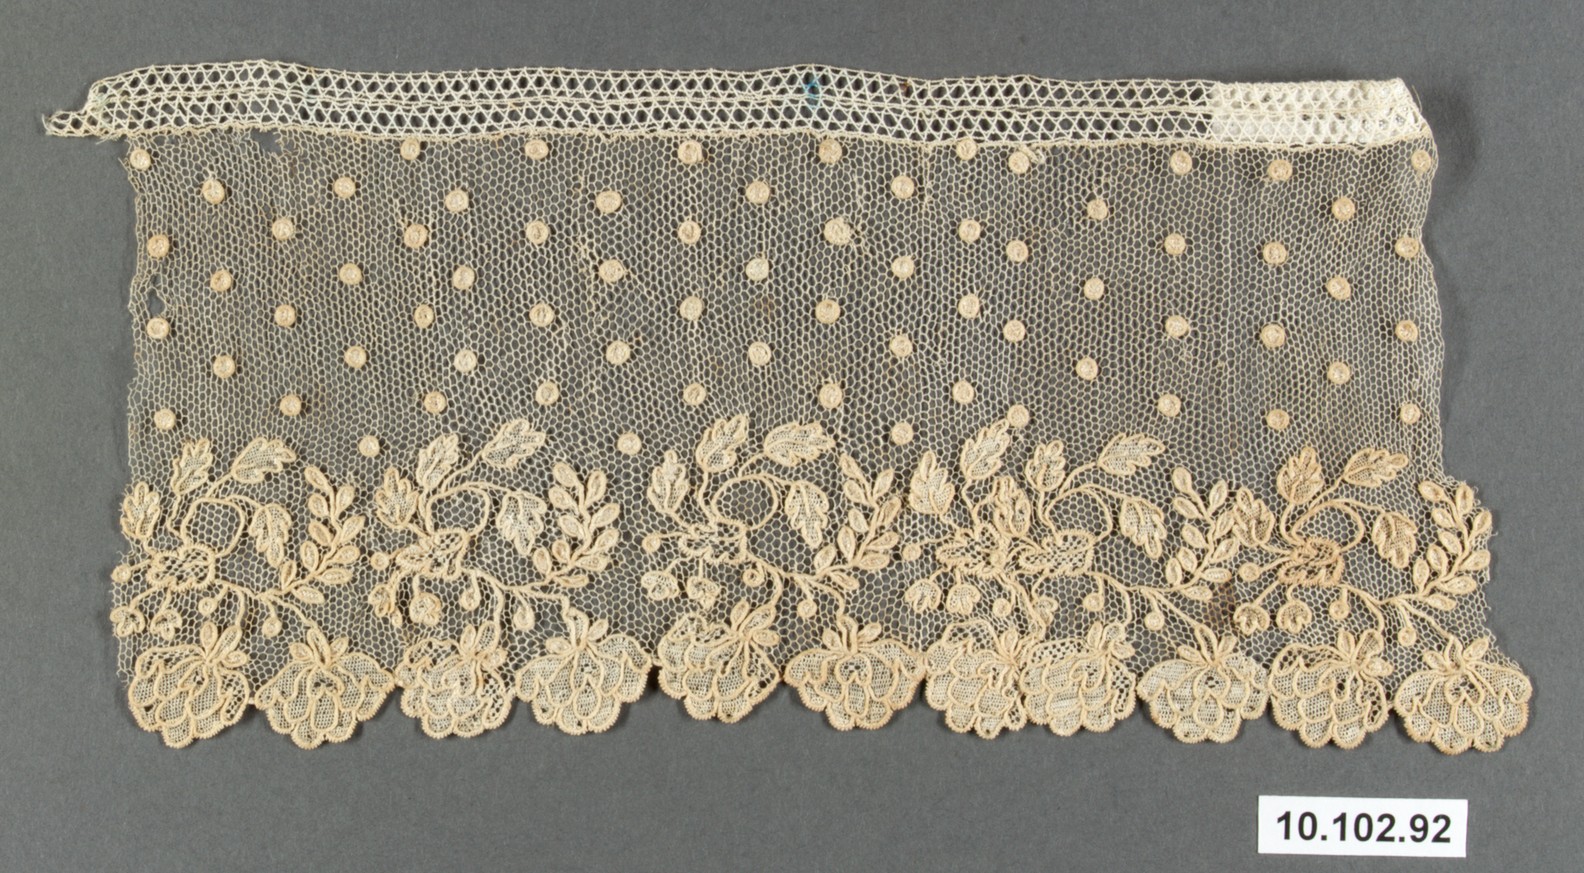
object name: fragment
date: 1801-1900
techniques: lace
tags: flowers,leaves